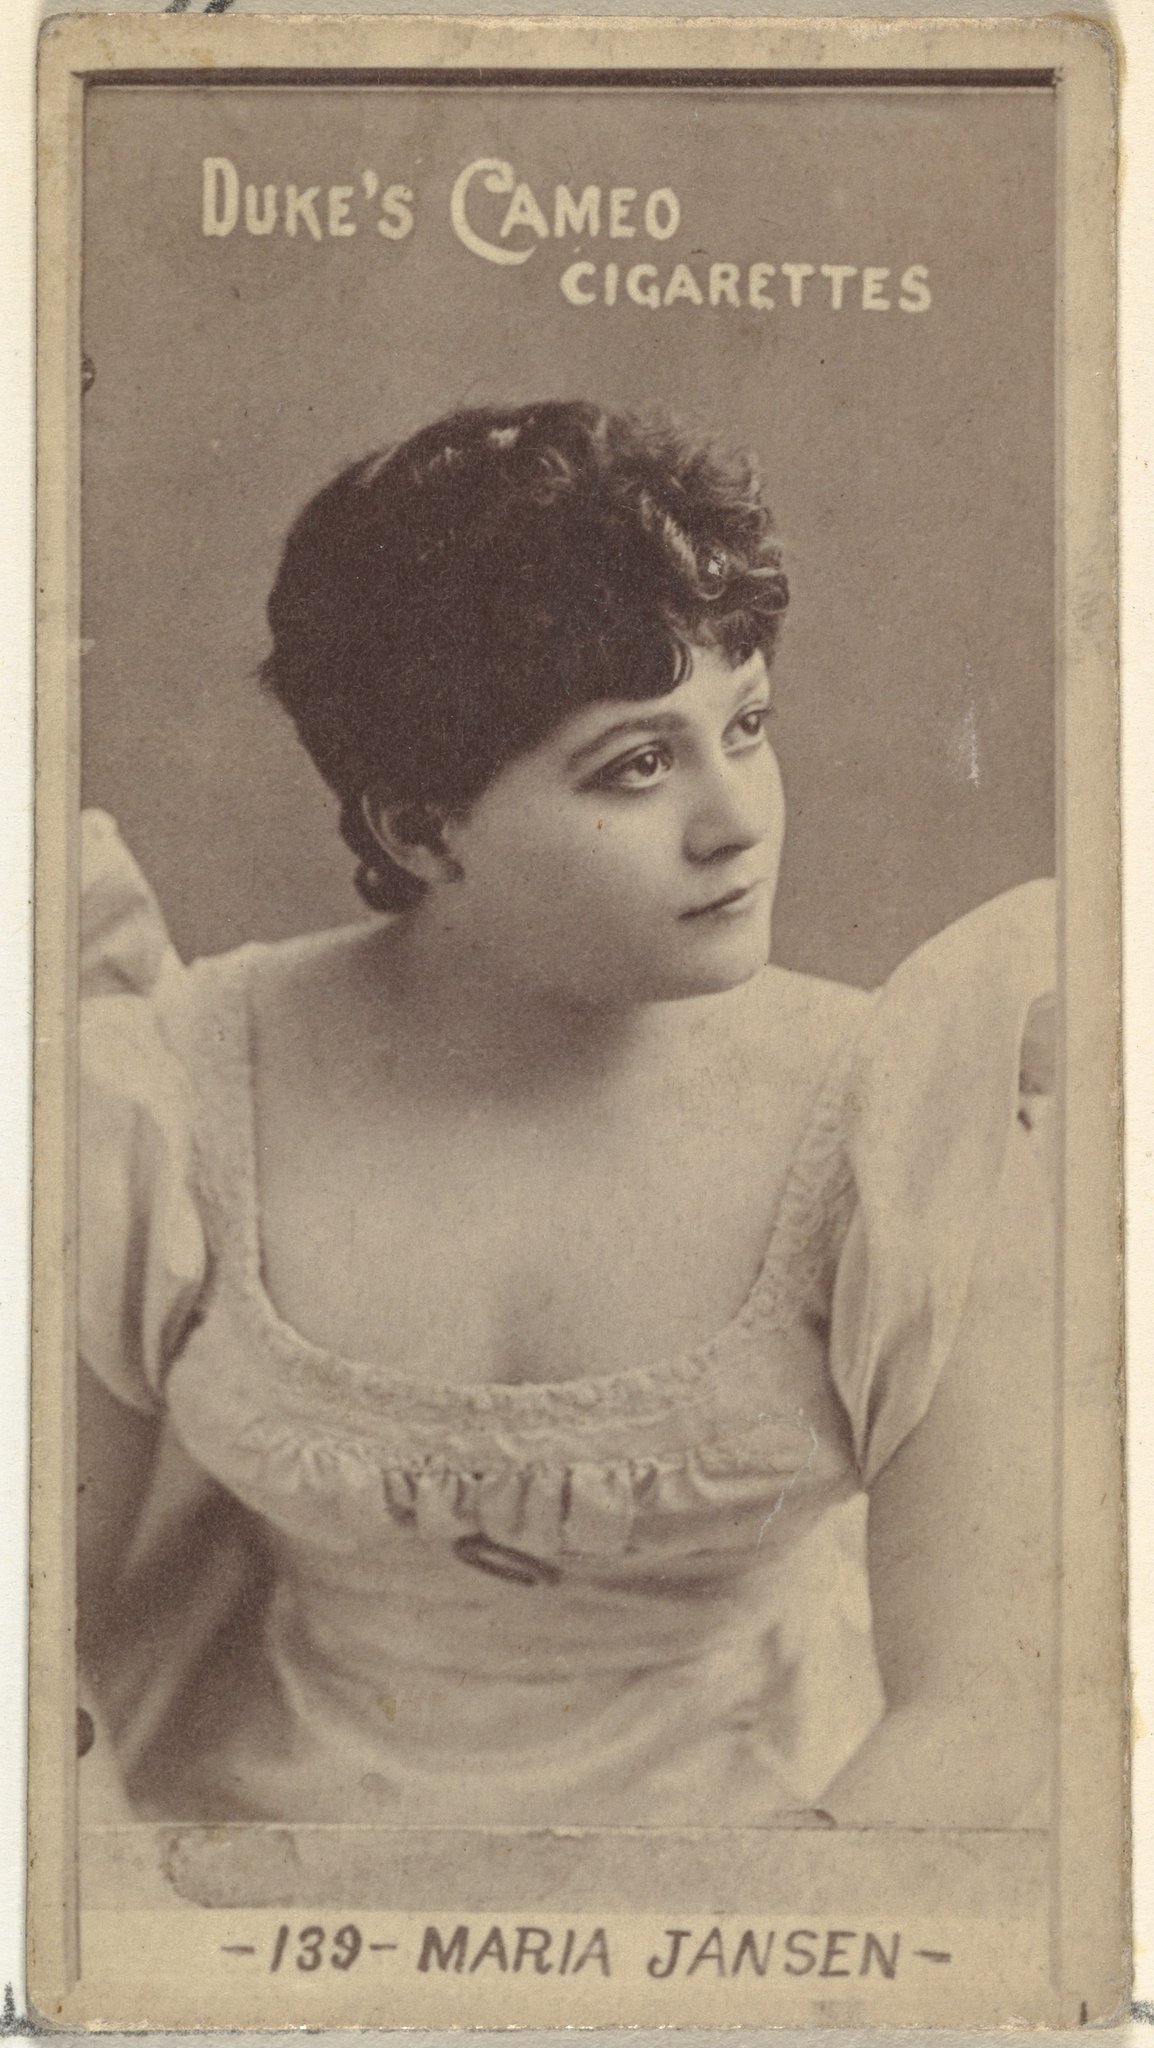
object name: photograph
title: Card Number 139, Marie Jansen, from the Actors and Actresses series (N145-4) issued by Duke Sons & Co. to promote Cameo Cigarettes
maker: w. duke, sons & co.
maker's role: publisher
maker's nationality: american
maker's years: 1870-1920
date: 1880-1889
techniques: albumen silver print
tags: portraits,women,actresses